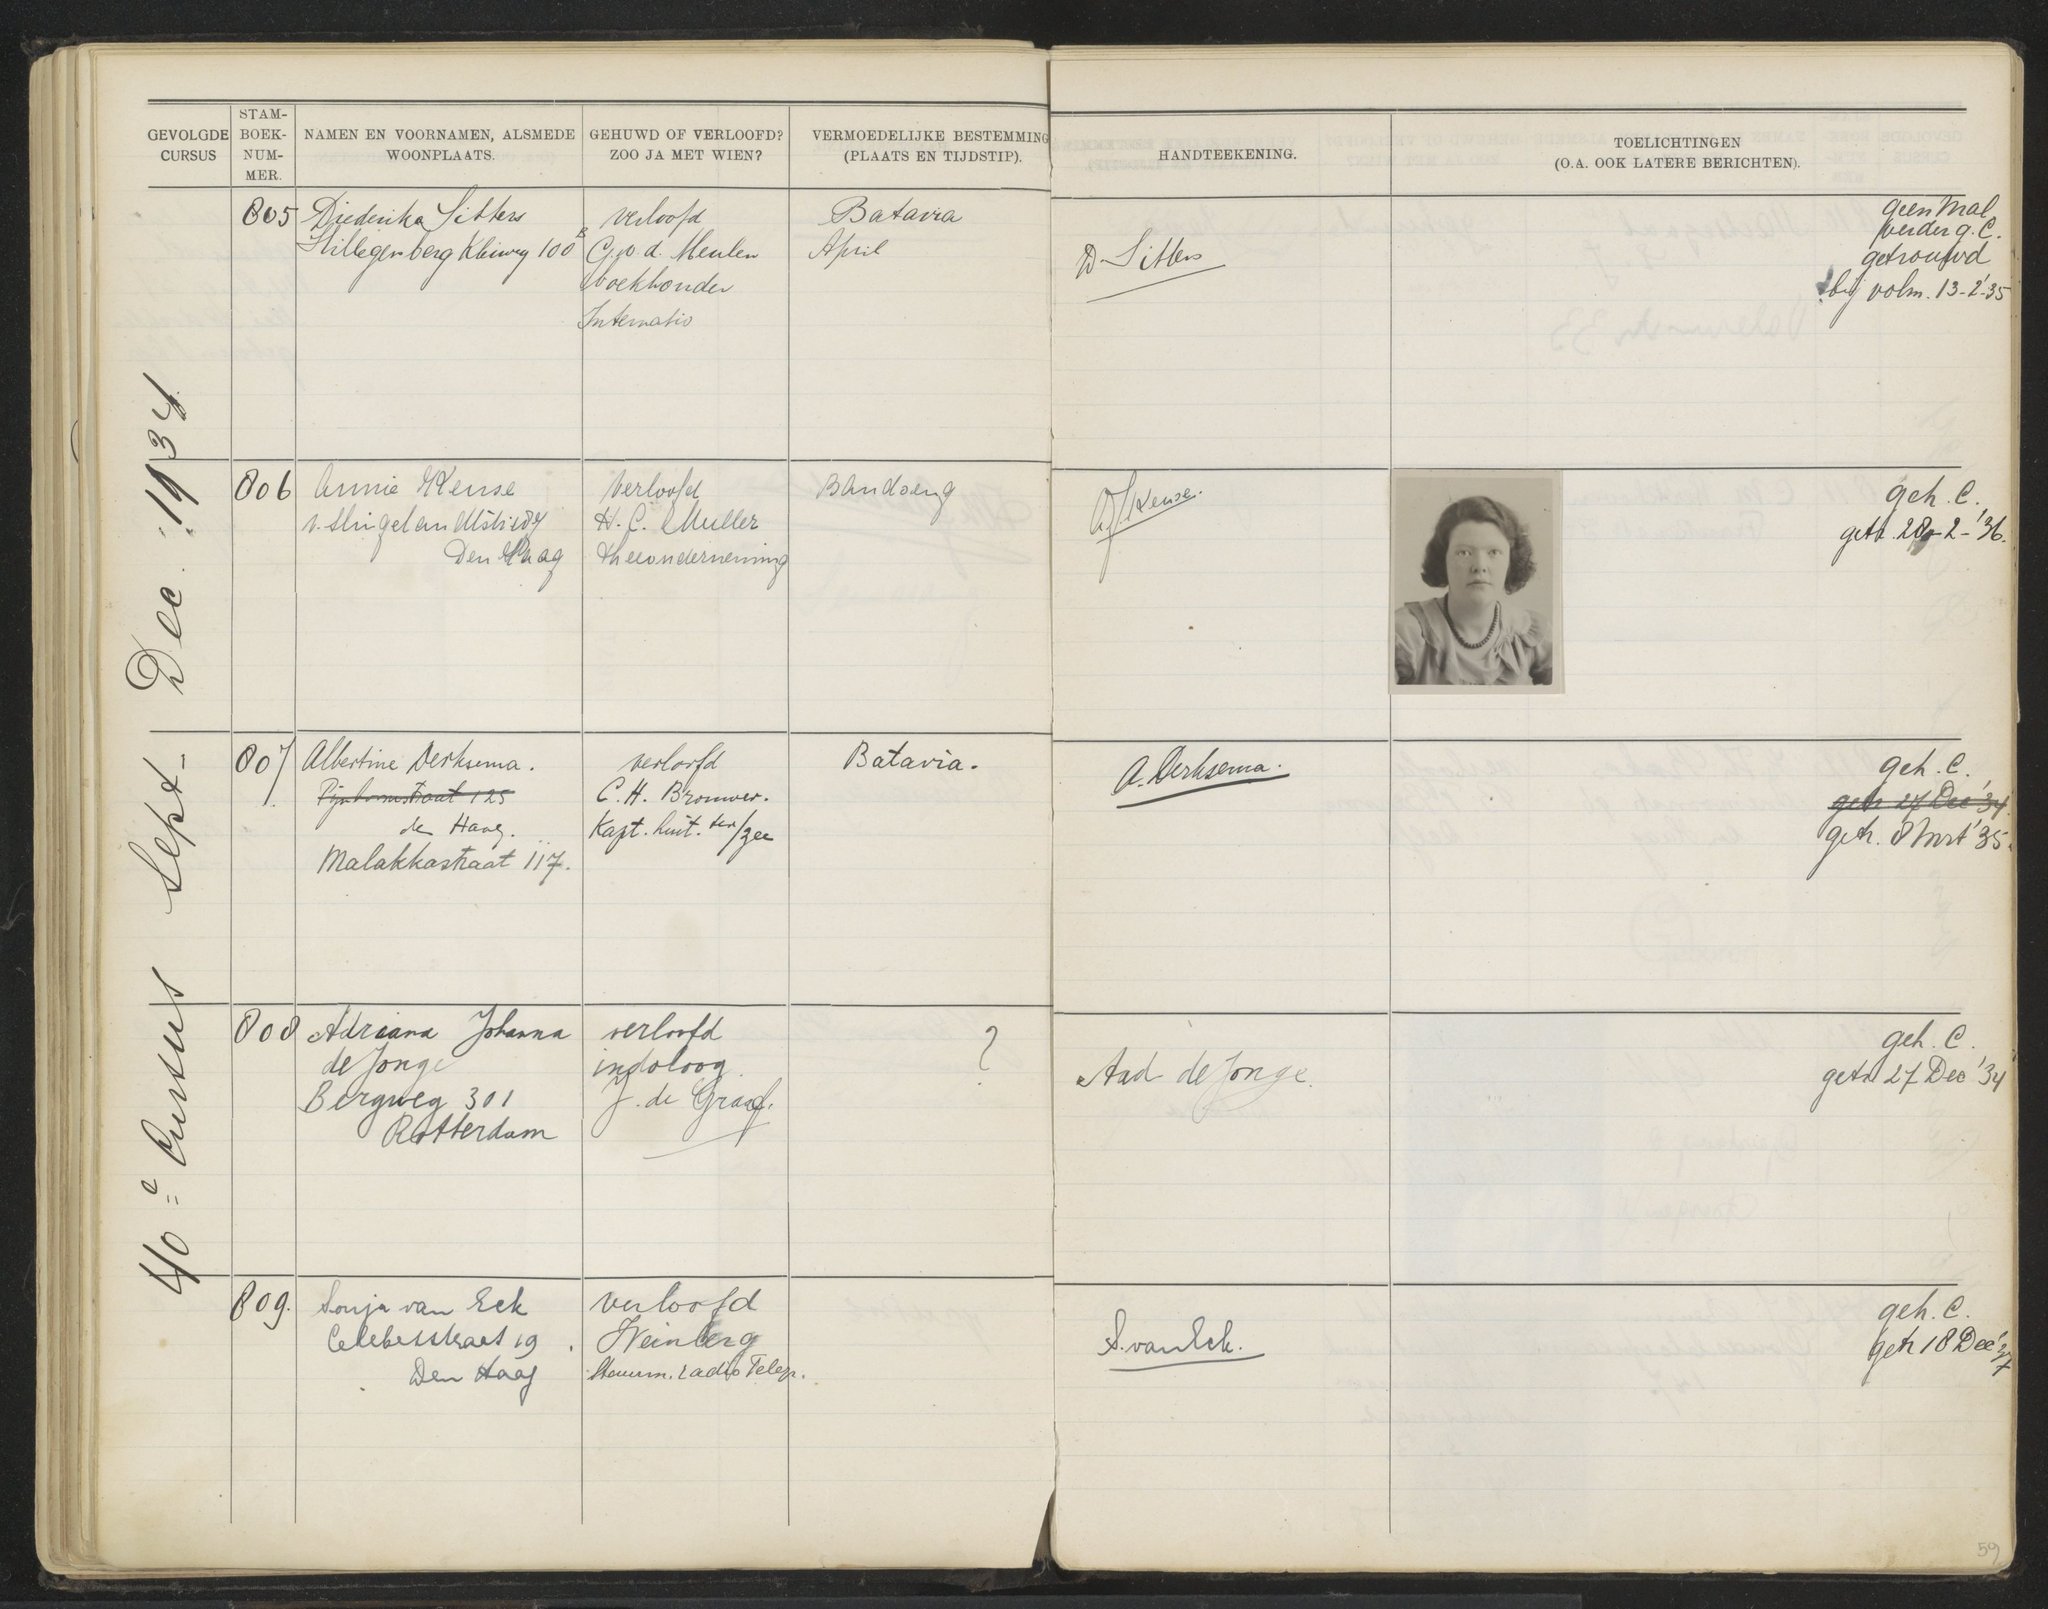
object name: photograph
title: Blad 59 uit Stamboek van de leerlingen der Koloniale School voor Meisjes en Vrouwen te 's-Gravenhage deel II (1930-1949)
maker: Anonymous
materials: paper, photographic support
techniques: photography, printing, writing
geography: the hague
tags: further education (+ pupil), further education, the hague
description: Twee pagina's met gegevens van de deelnemers aan de 40e driemaandelijkse cursus van september tot december 1934, stamboeknummers 805 tot en met 809. Onderdeel van Stamboek van de leerlingen der Koloniale School voor Meisjes en Vrouwen te 's-Gravenhage deel II (1930-1949).